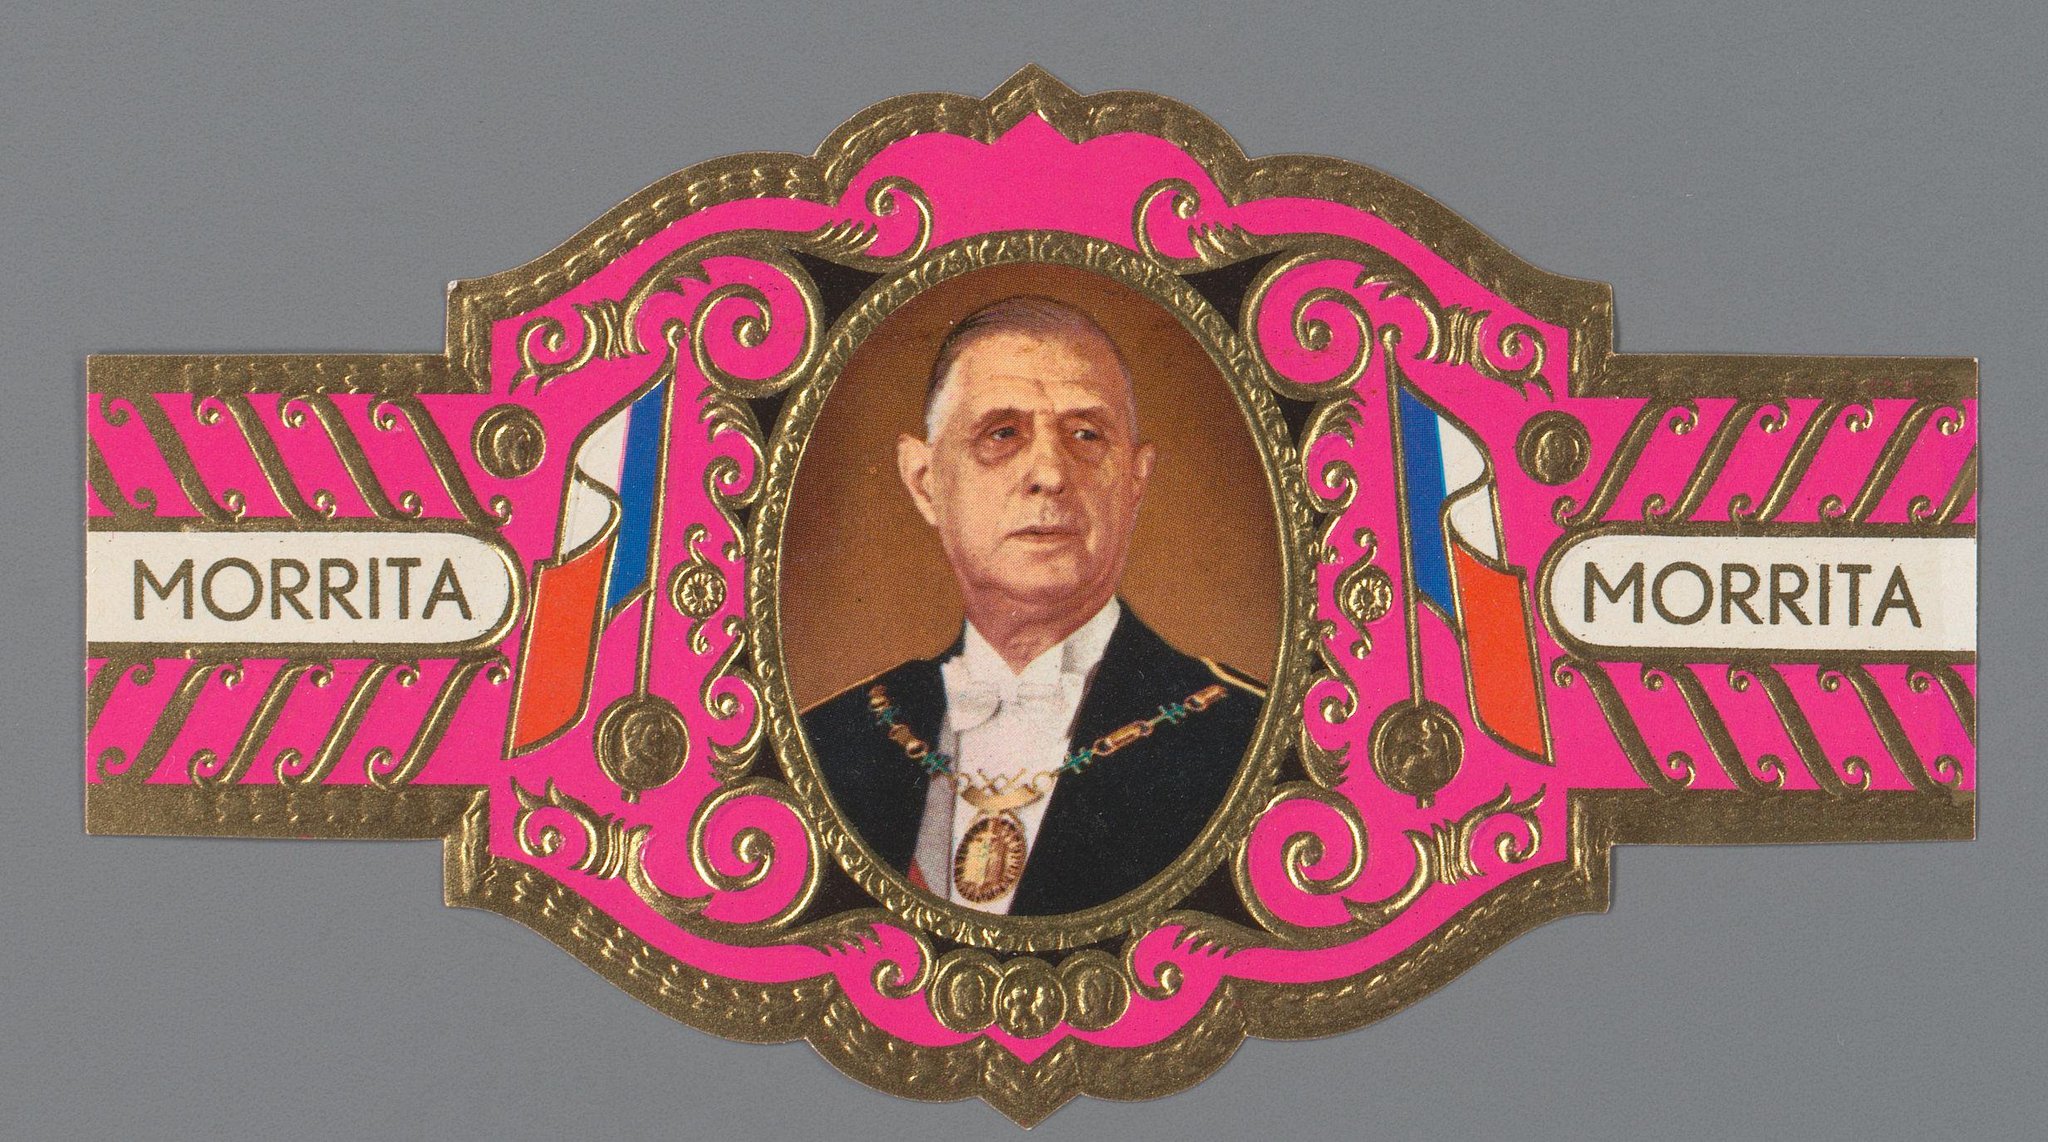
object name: cigar band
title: Portret van president Charles de Gaulle van Frankrijk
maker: Anonymous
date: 1959-1969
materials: paper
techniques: blind stamped, printing block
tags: president ~ head of republic, historical persons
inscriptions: inscription: ‘Morrita’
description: Aan weerszijden van het portret is tweemaal de vlag van het land afgebeeld.